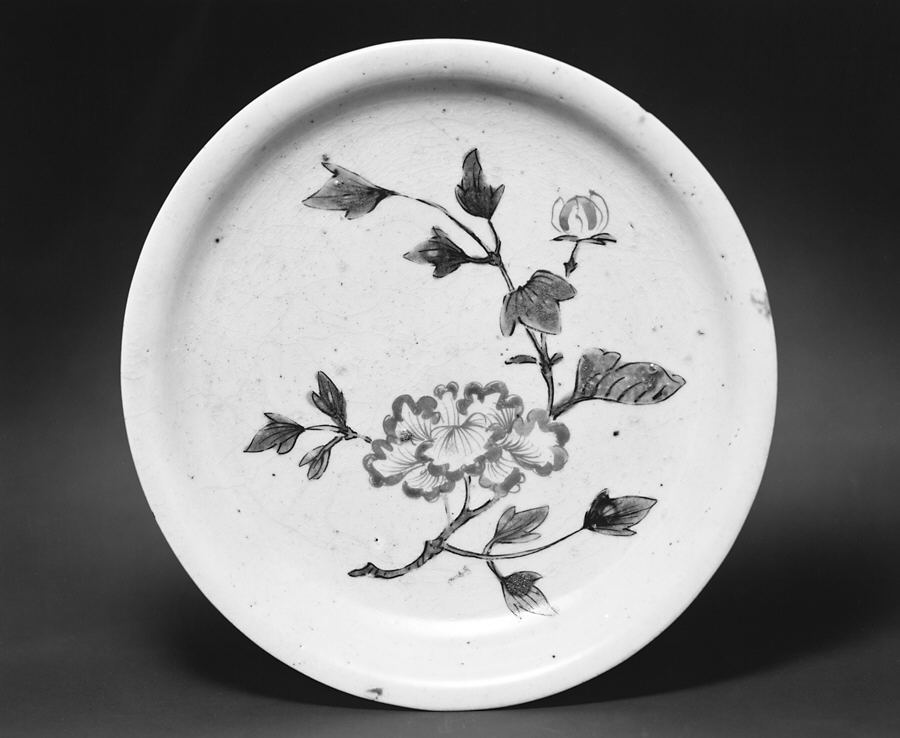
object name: dish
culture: japanese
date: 1650-1700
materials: enamel, porcelain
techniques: painting, polychrome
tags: flowers,leaves